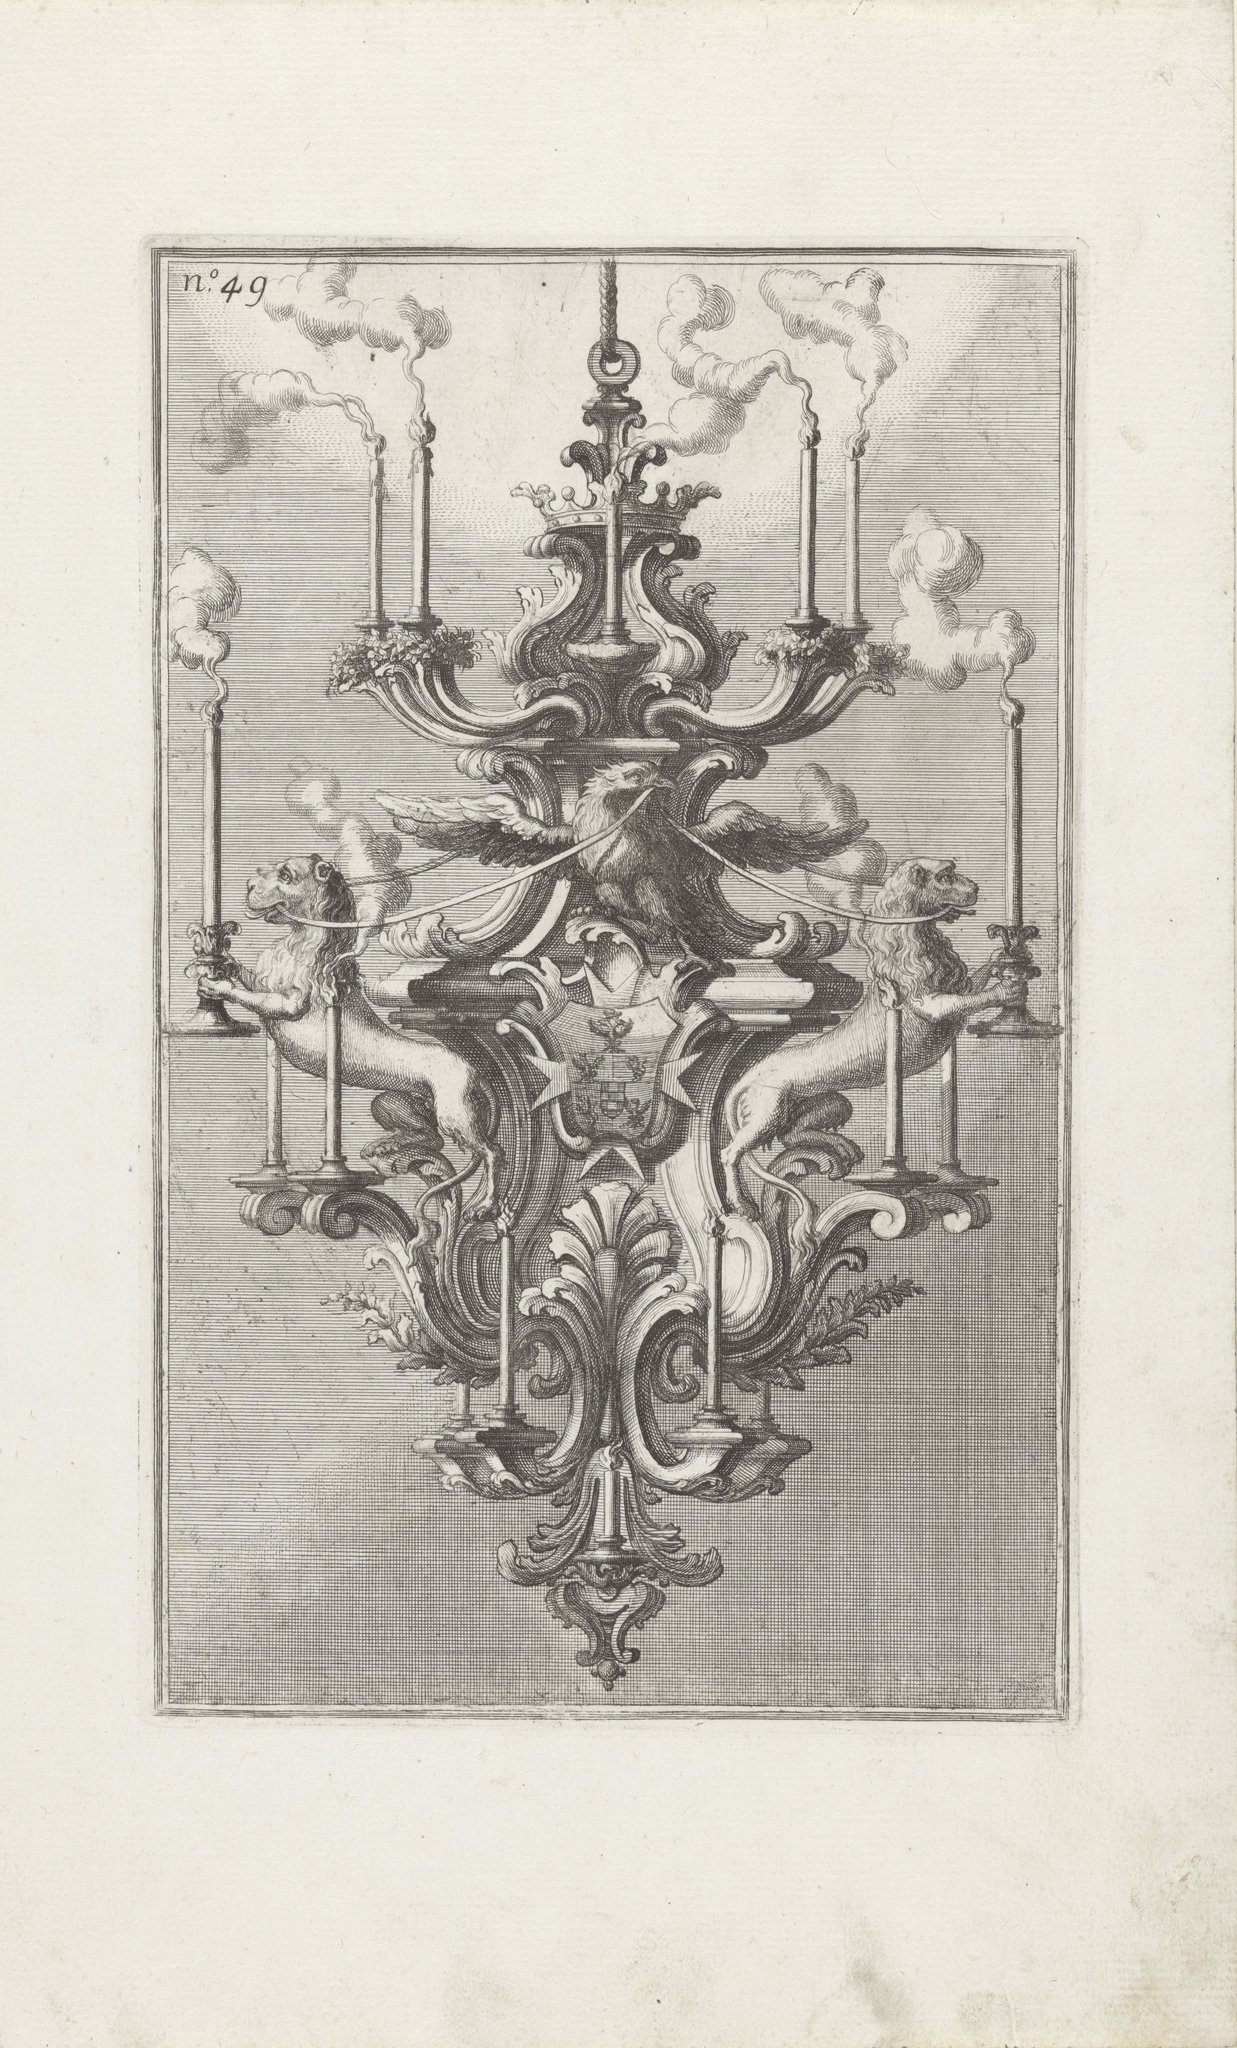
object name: ornament print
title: Disegni diversi inventati e delineati da Giovanni Giardini da Forlì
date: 1714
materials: paper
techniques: etching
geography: italy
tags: coat of arms (symbol of sovereignty), predatory birds: eagle, chandelier, candelabrum, candle, beasts of prey, predatory animals: lion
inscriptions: collector's mark: Lugt 2228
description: Prent maakt deel uit van een reeks van 100 ornamentprenten naar ontwerp van Giovanni Giardini.